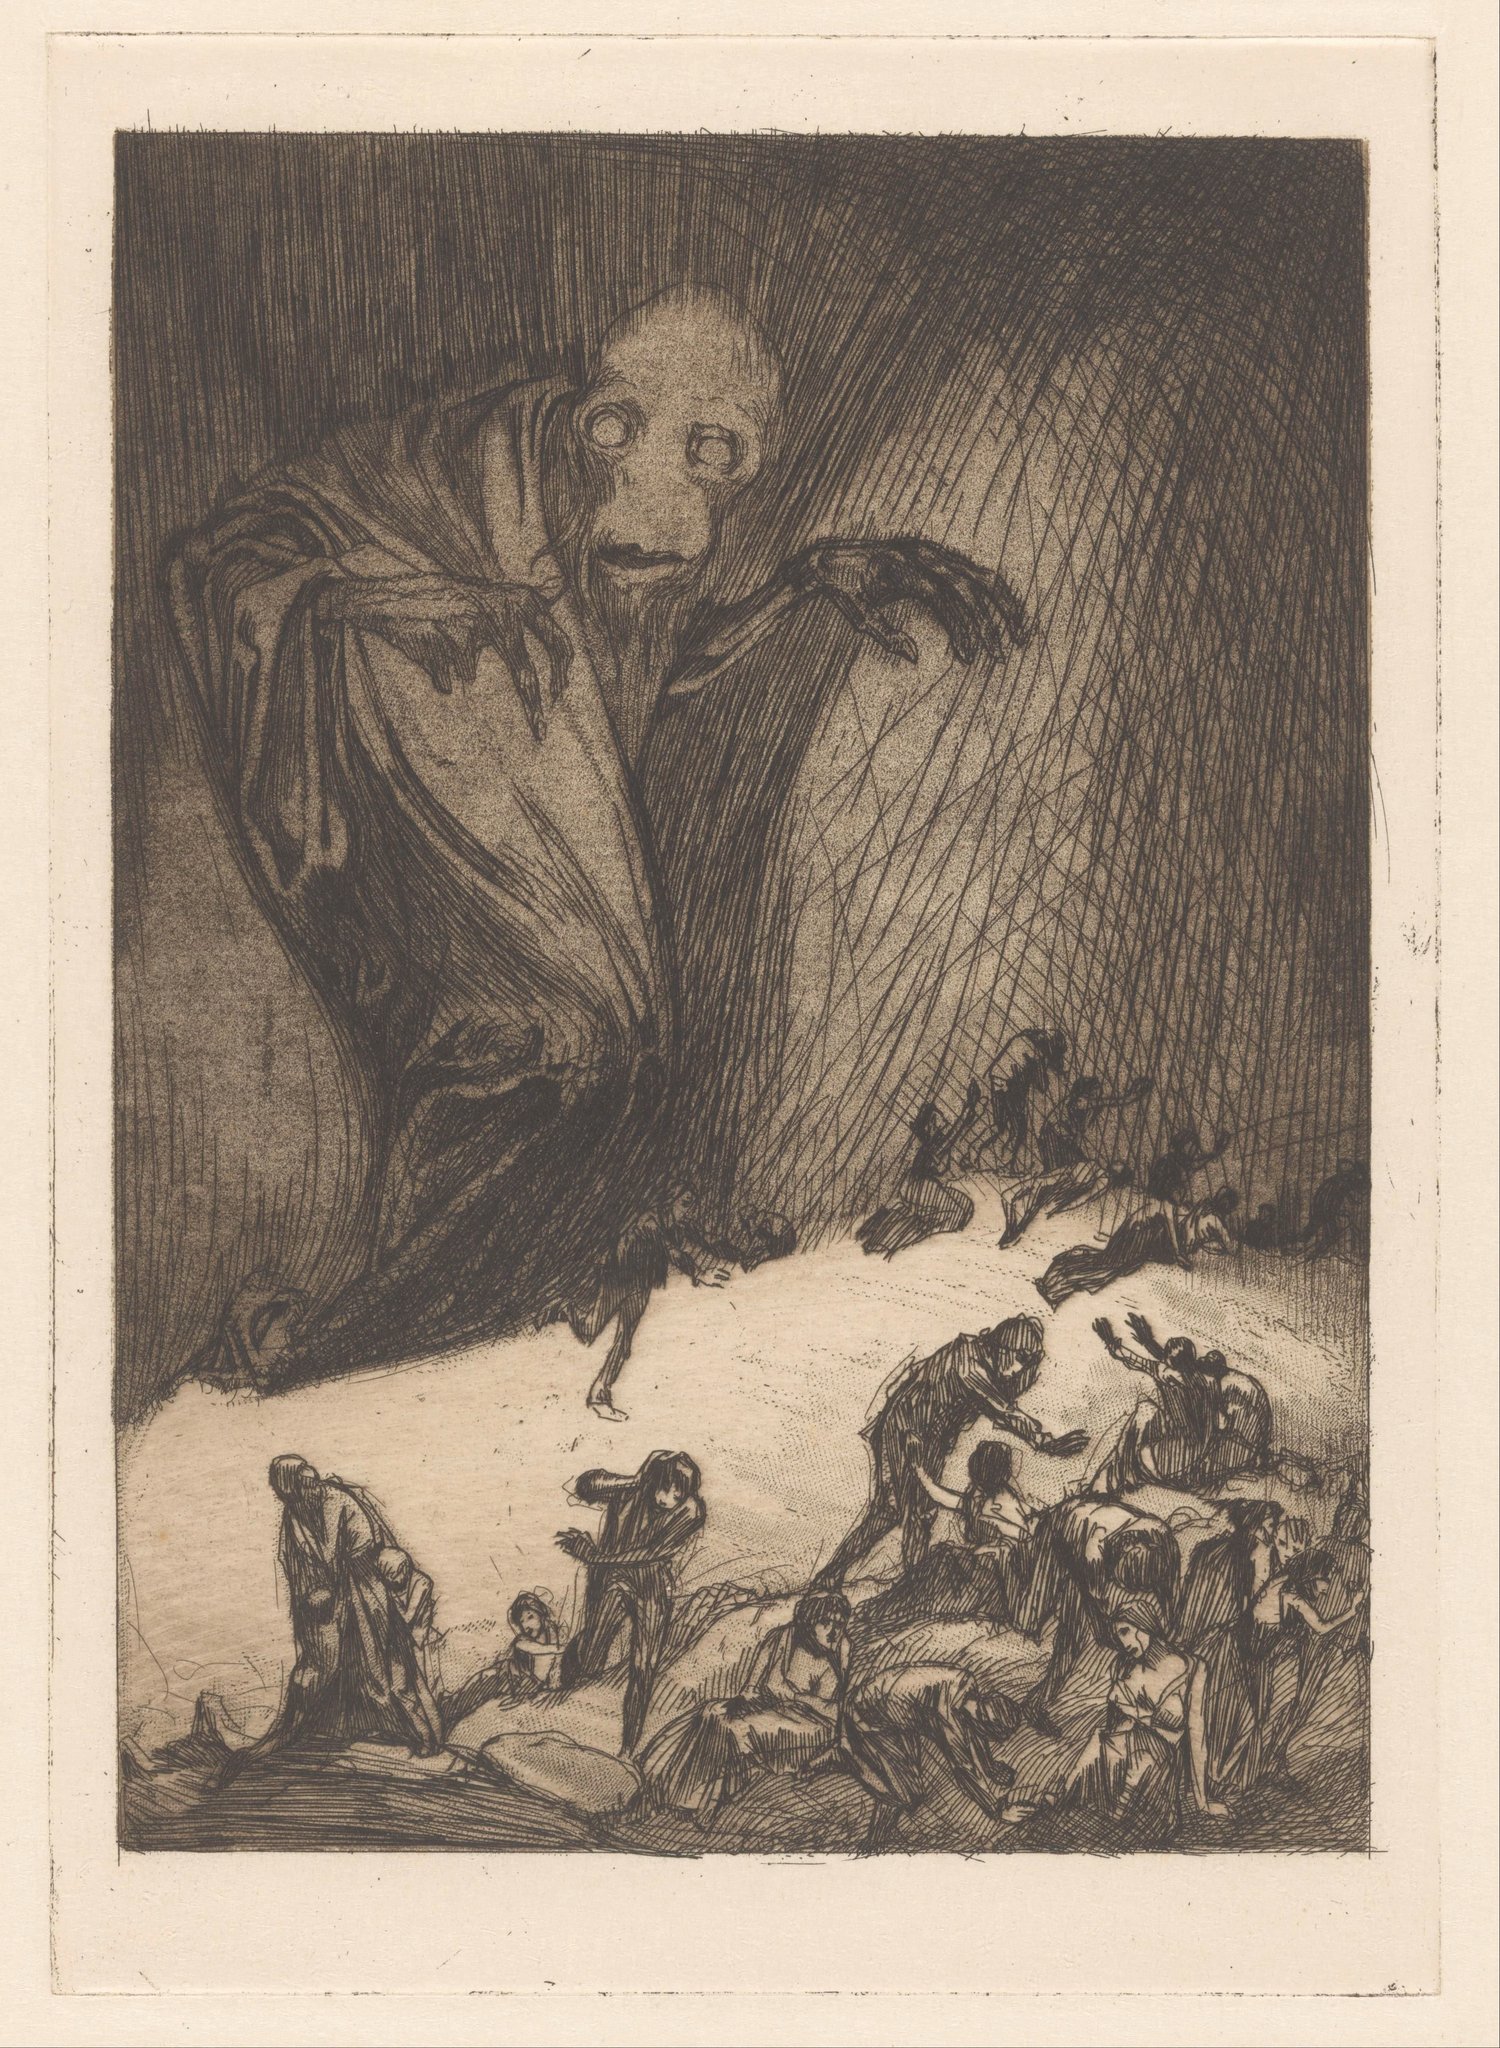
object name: print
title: Monsterfantasie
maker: johannes josephus aarts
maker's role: draughtsman, print maker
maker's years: 1871-1934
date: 1881-1934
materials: paper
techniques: aquatint, etching, roulette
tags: monsters larger than normal, flight, running away; pursuing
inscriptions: collector's mark: Lugt 2228, collector's mark: Lugt 2760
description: Een monster met holle ogen en gekleed in een gewaad verheft zich boven een menigte mensen, die voor hem wegvlucht. Sommige mensen heffen hun armen ten hemel.